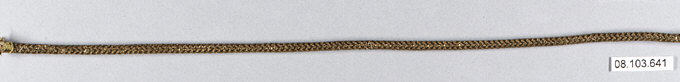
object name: cord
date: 1701-1900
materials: metal thread